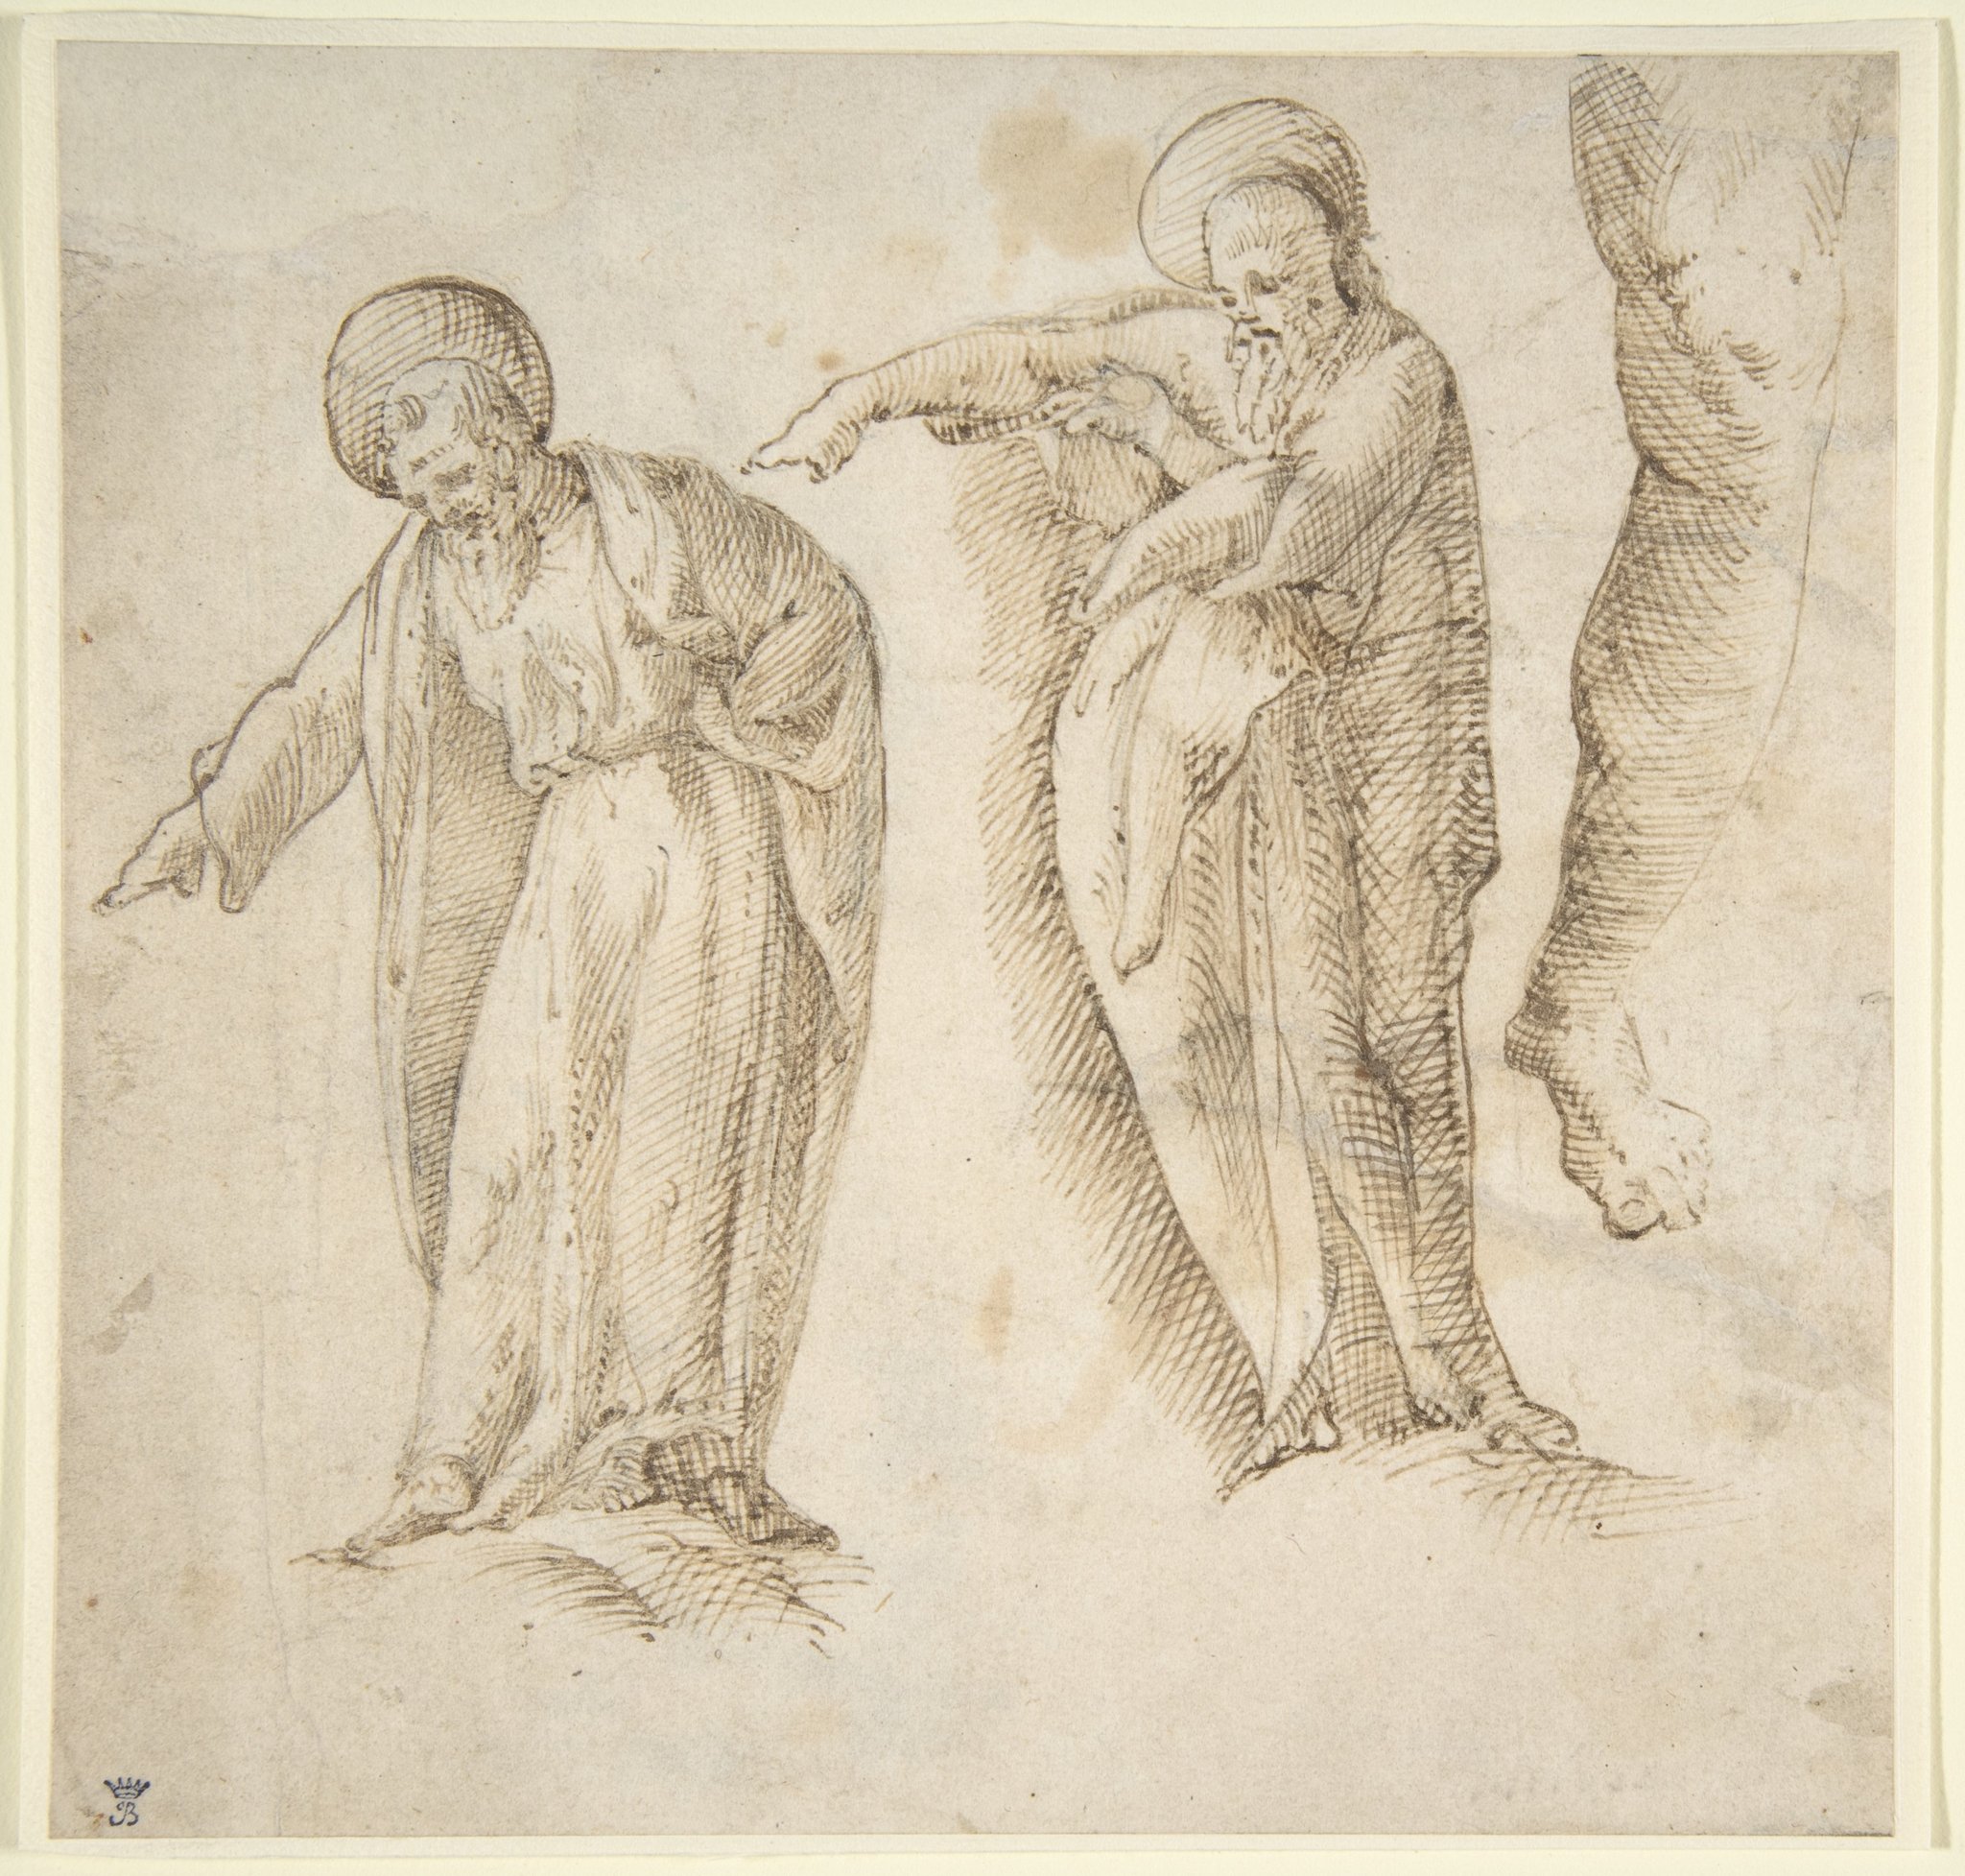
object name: drawing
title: Studies for the Standing Figure of a Bearded Man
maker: anonymous, italian, 16th century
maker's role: artist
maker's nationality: italian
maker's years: 1550-1600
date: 1530-1550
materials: chalk, ink, drawing material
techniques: pen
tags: men